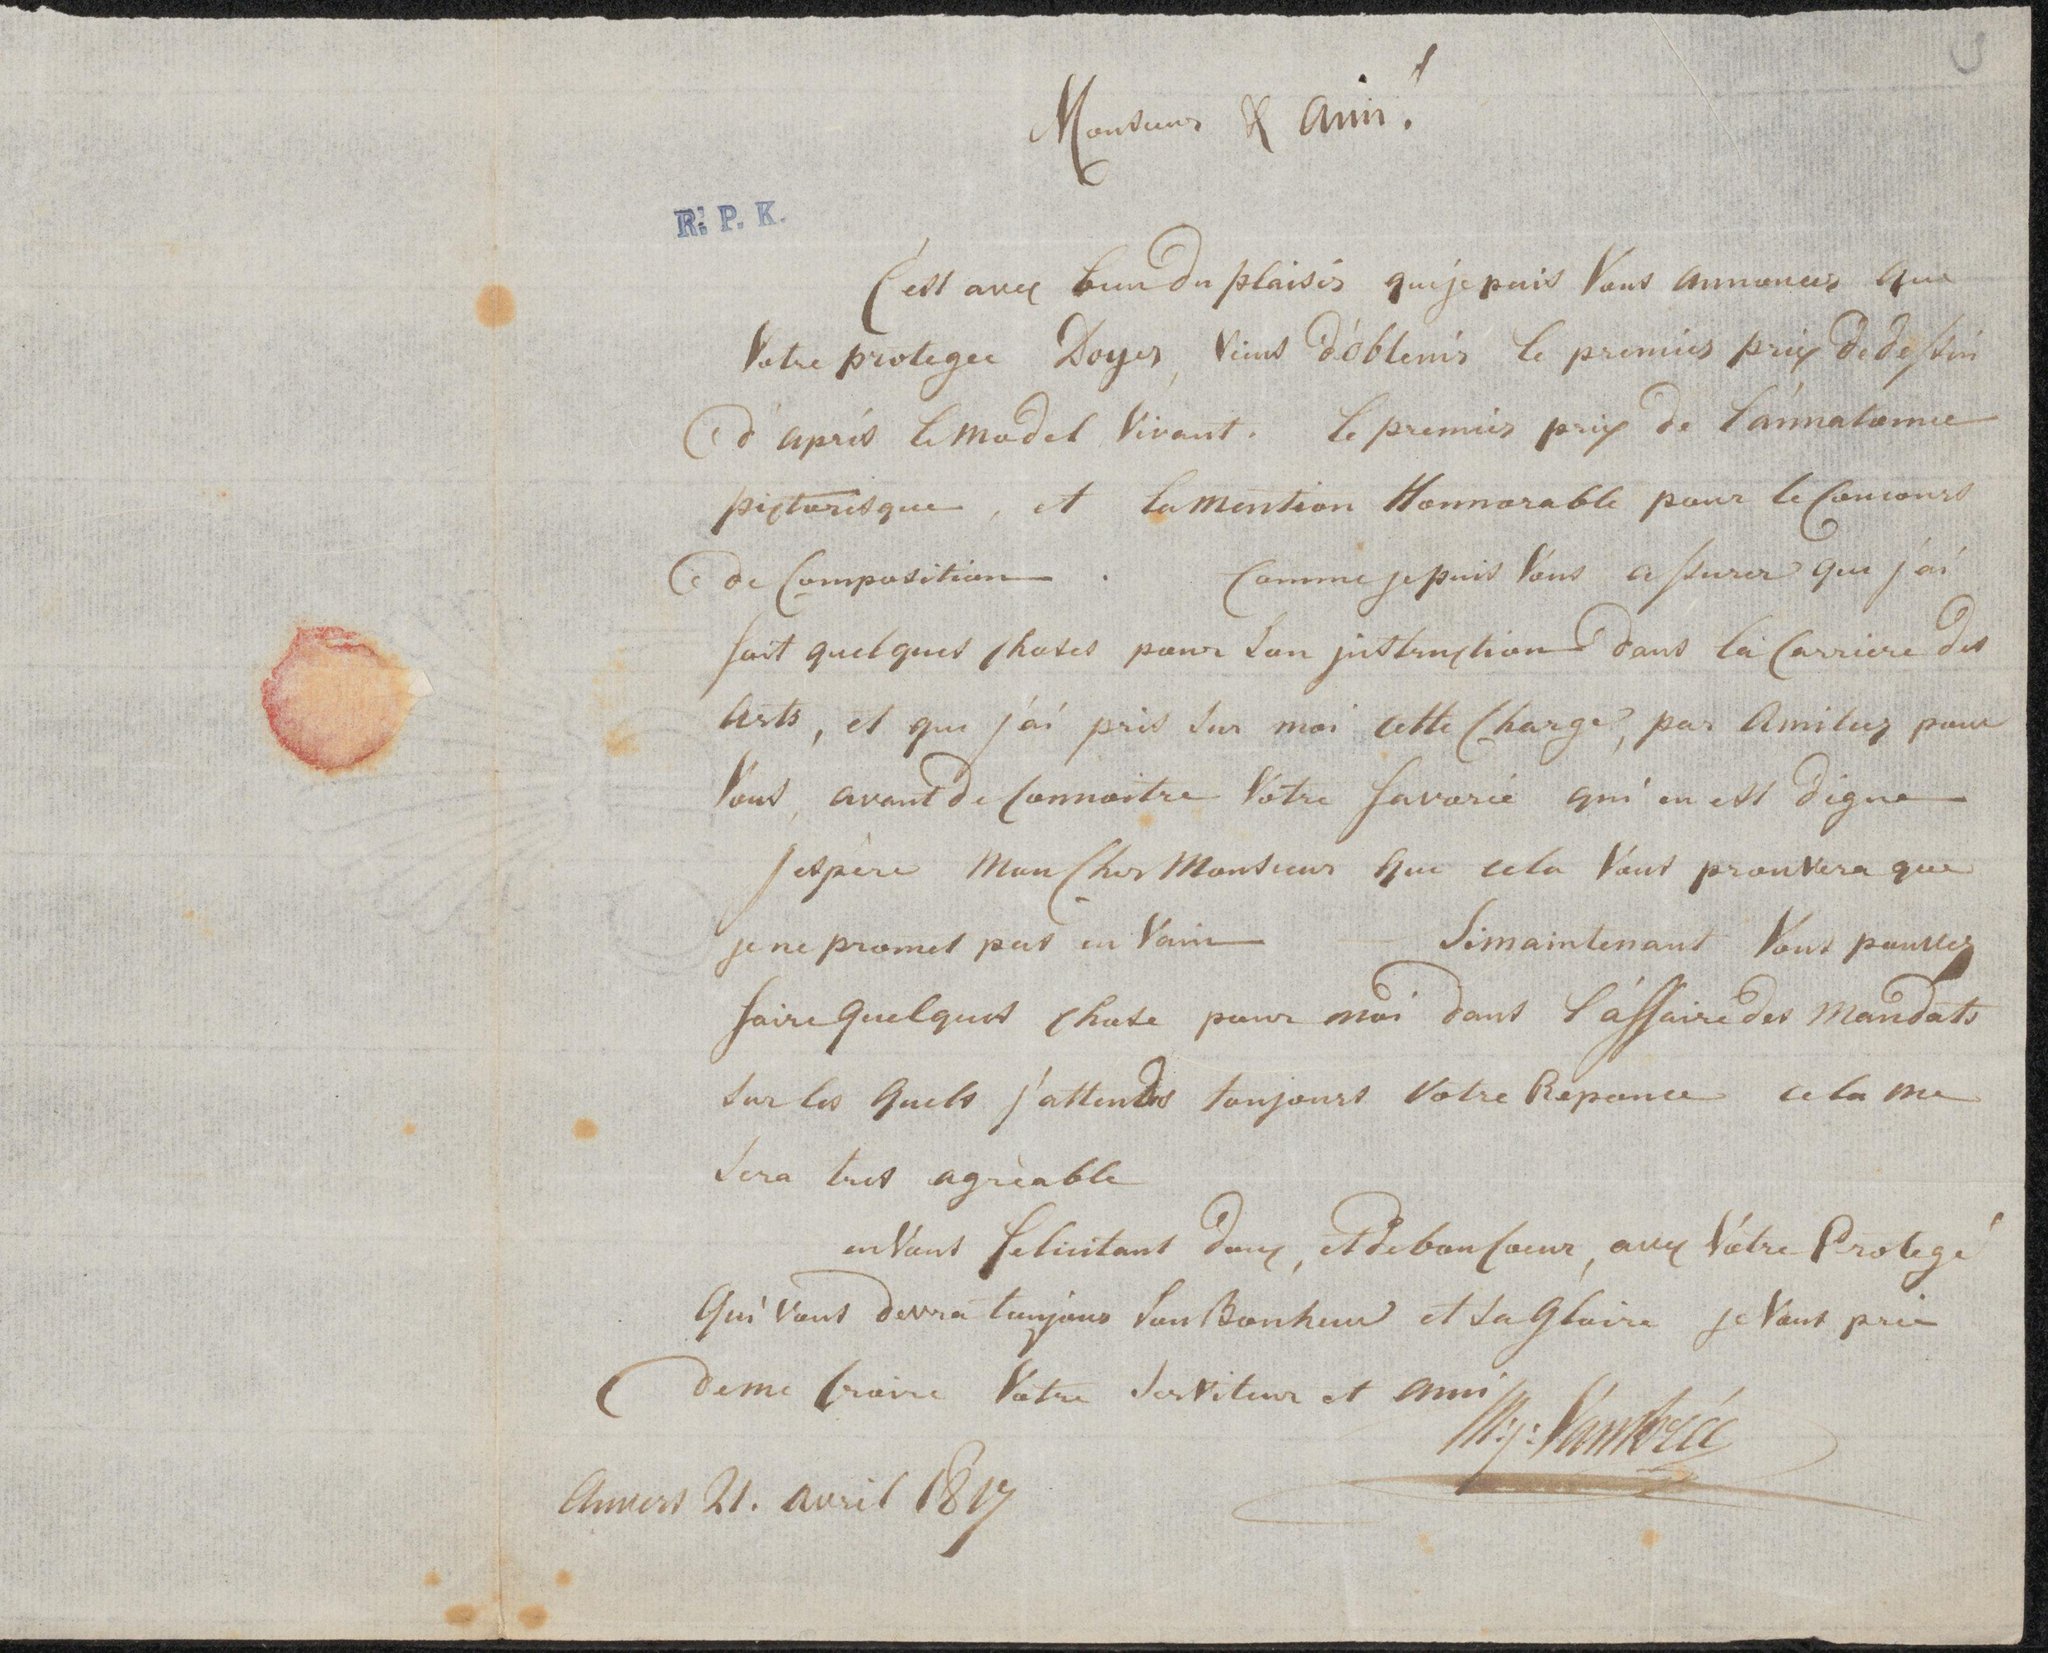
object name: letter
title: Brief aan onbekend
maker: mattheus ignatius van bree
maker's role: draughtsman, print maker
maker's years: 1773-1839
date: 1817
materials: ink, paper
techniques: pen, writing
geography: antwerp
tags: artist's model, sitter, distribution of awards ~ art contest, painting (including book-illumination, miniature-painting)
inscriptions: watermark, collector's mark: Lugt 2233